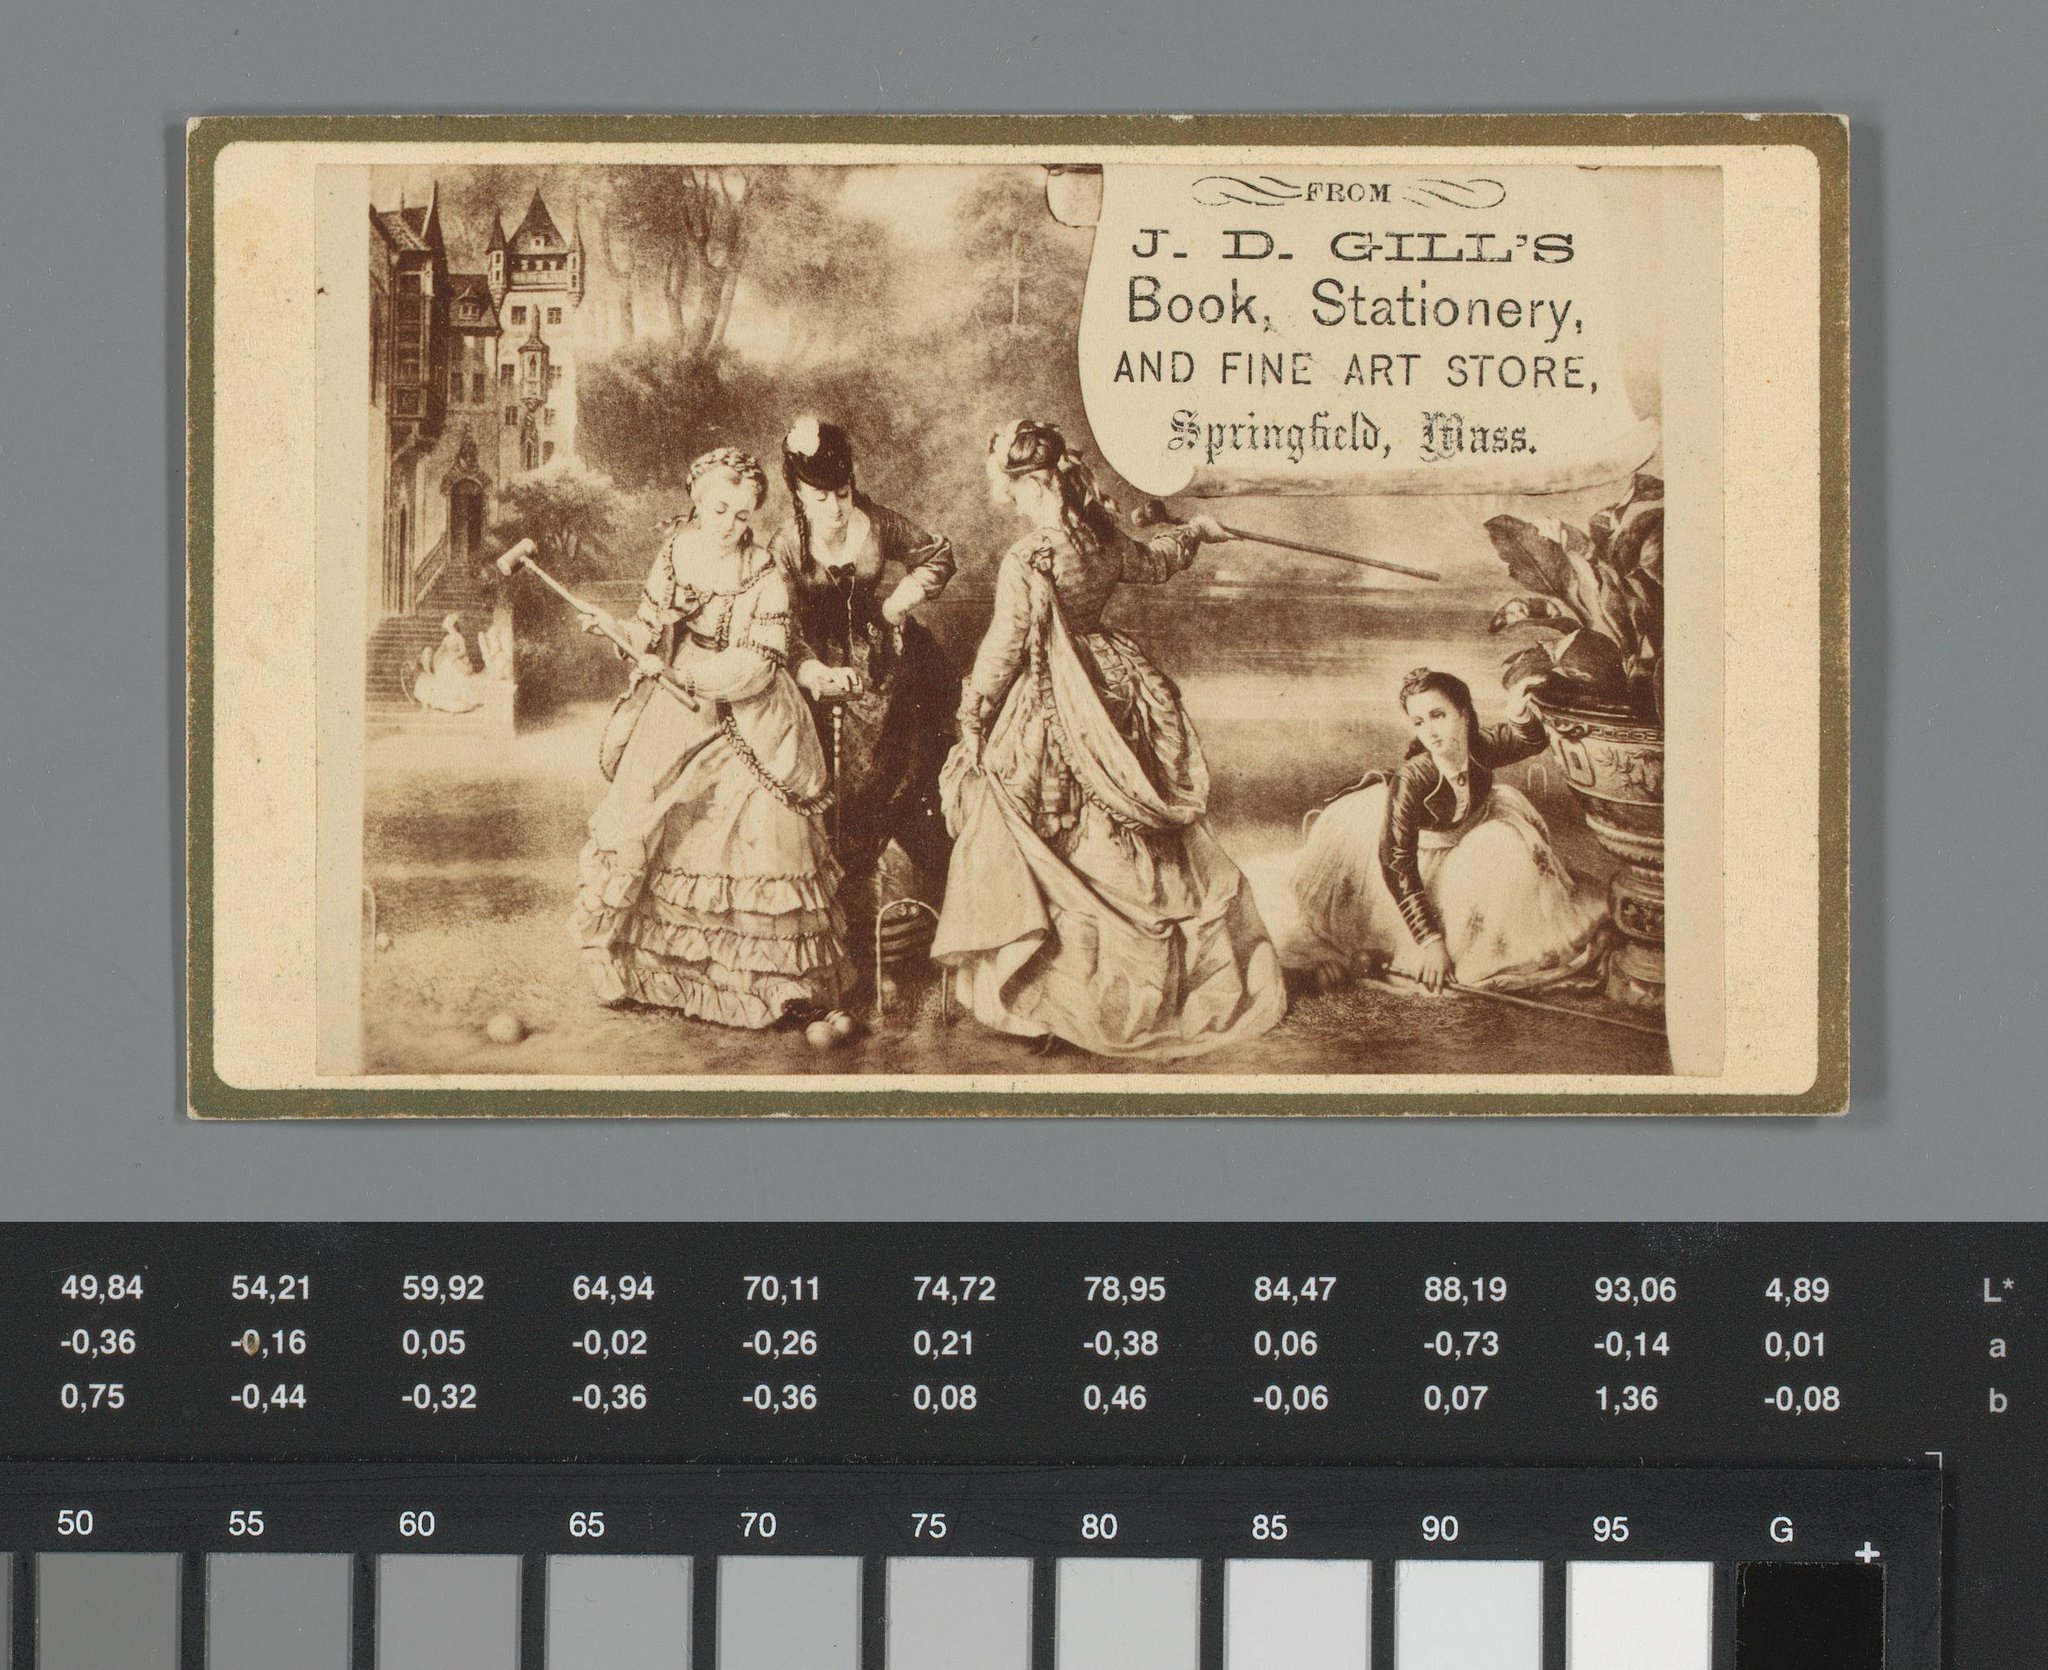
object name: reproduction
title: Reclame voor de winkel van J.D. Gill in Springfield, Massachusetts, met een fotoreproductie van een prent van vrouwen die croquet spelen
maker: Anonymous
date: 1850-1915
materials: cardboard, photographic support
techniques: albumen print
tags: advertising, croquet